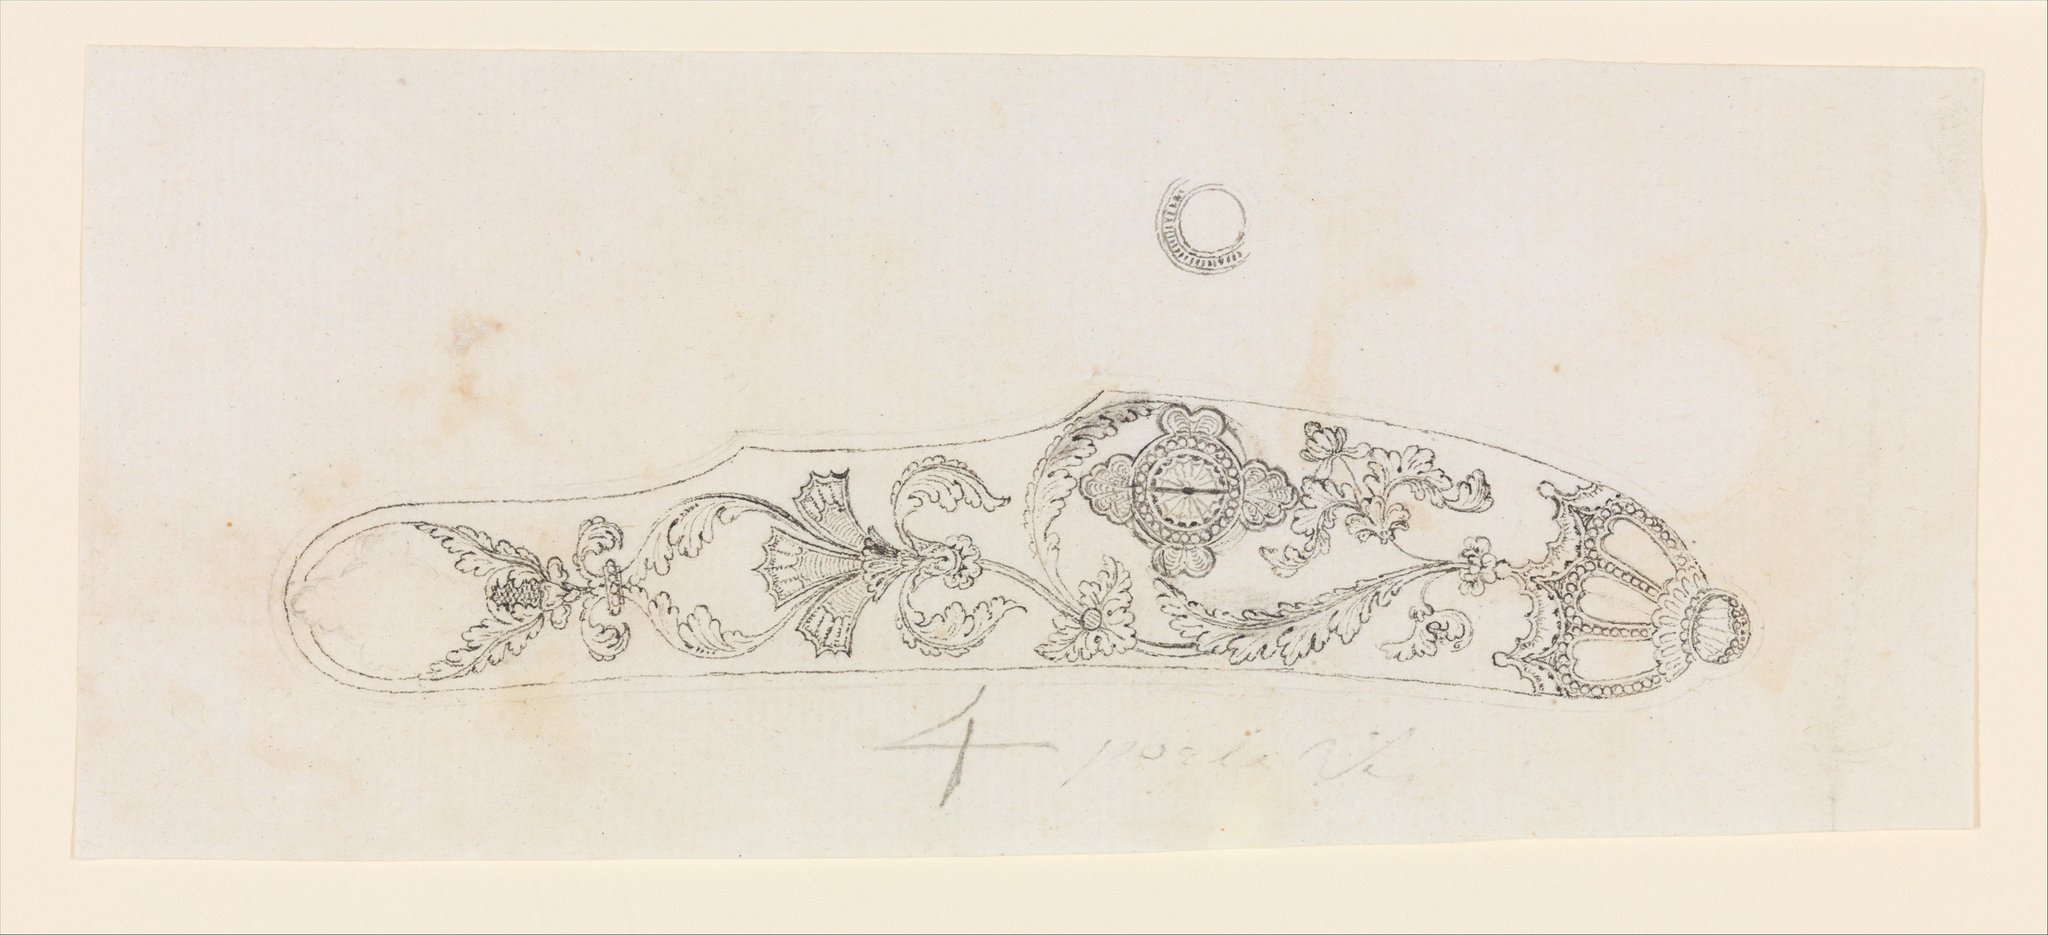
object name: drawing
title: Design for the Decoration of the Side Plate of a Firearm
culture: french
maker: nicolas noël boutet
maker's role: designer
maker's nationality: french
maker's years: 1761-1833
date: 1797-1805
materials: ink, paper, pencil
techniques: wash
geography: france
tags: ornament